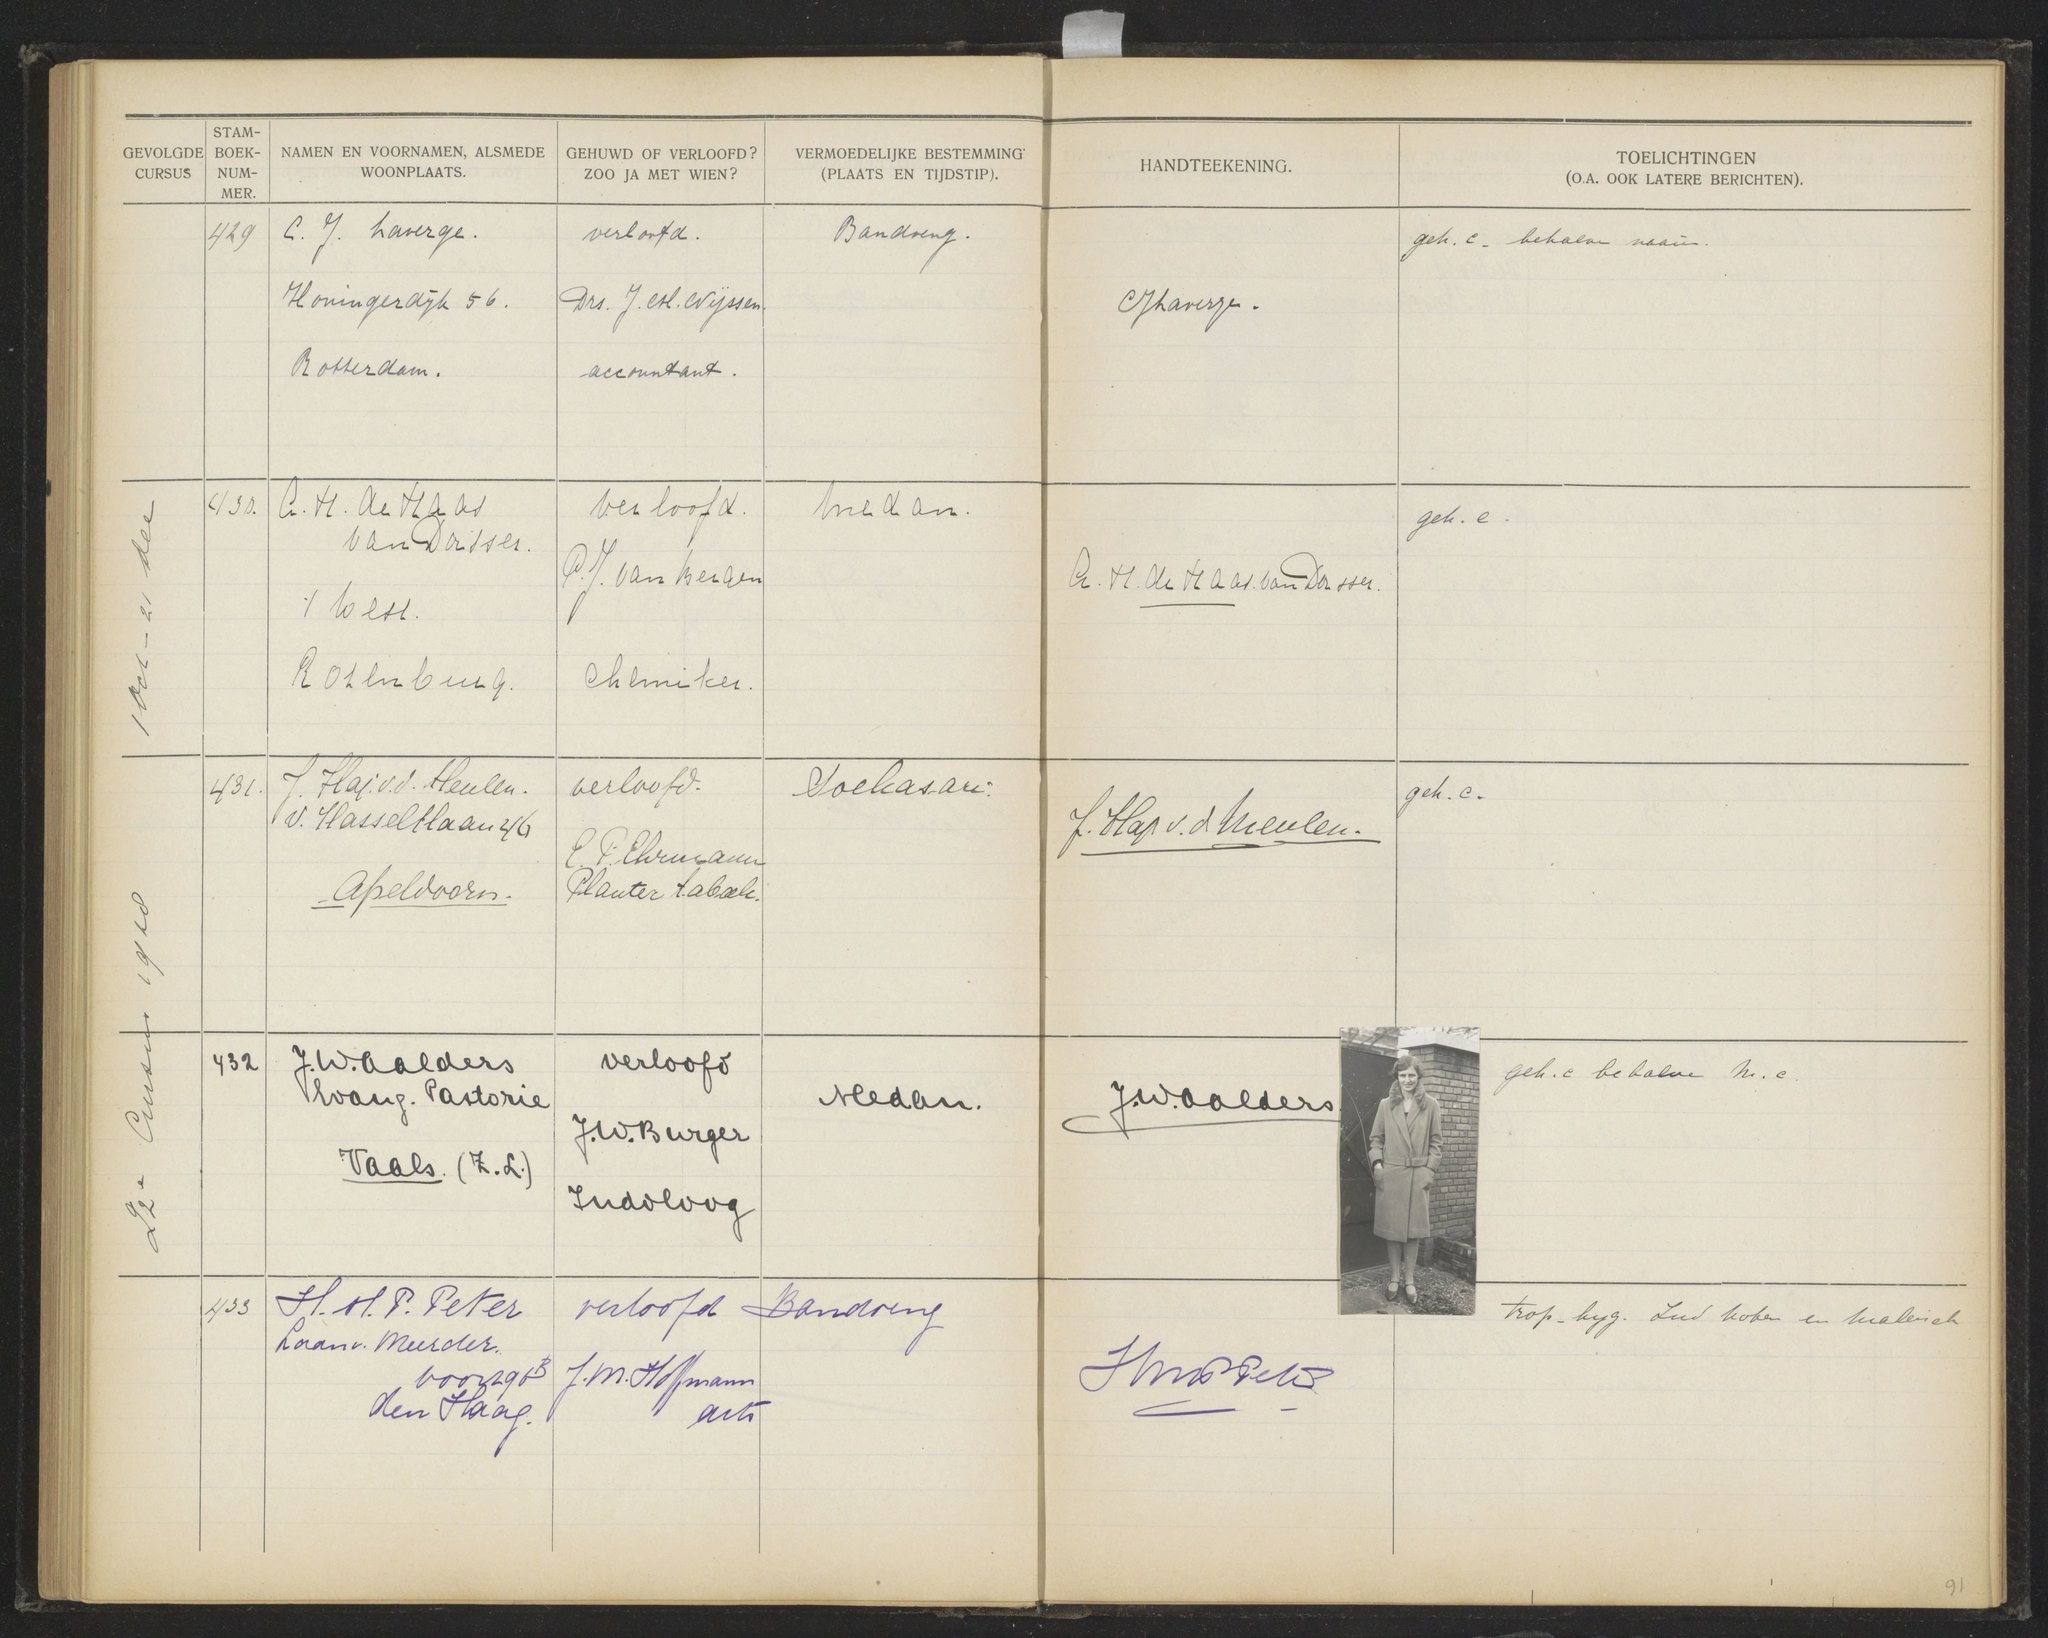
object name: photograph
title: Blad 91 uit Stamboek van de leerlingen der Koloniale School voor Meisjes en Vrouwen te 's-Gravenhage deel I (1921-1929)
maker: Anonymous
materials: paper, photographic support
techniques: photography, printing, writing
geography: the hague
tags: further education (+ pupil), further education, the hague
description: Twee pagina's met gegevens van de deelnemers aan de 22e driemaandelijkse cursus van 1 oktober tot en met 21 december 1928, stamboeknummers 429 tot en met 433. Onderdeel van Stamboek van de leerlingen der Koloniale School voor Meisjes en Vrouwen te 's-Gravenhage deel I (1921-1929).